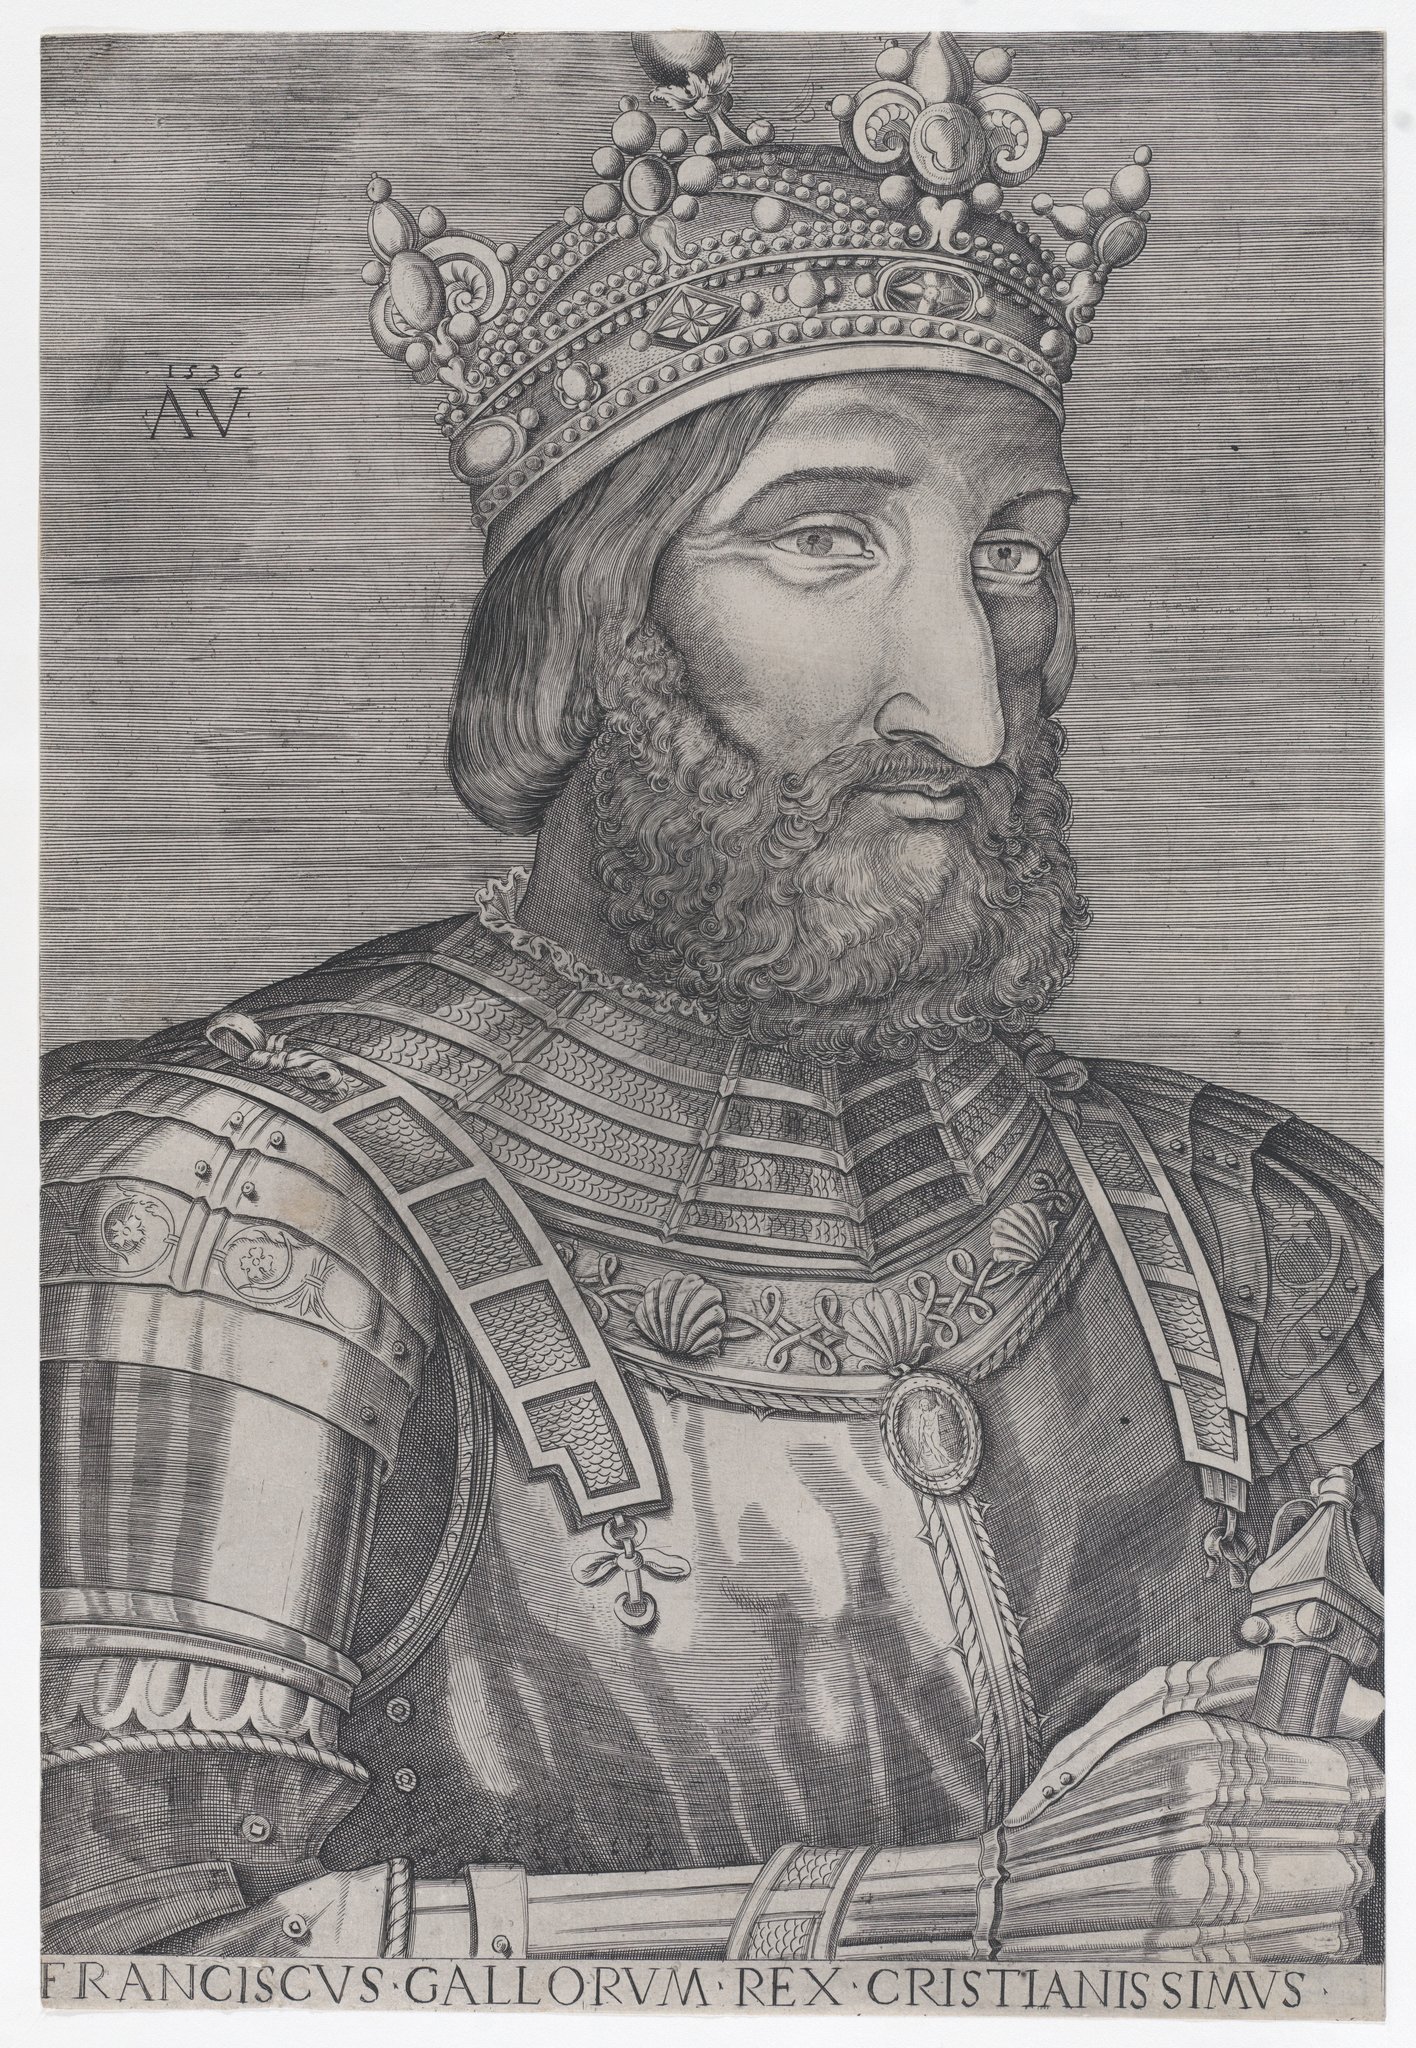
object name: print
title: Francois I, King of France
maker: agostino veneziano (agostino dei musi)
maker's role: artist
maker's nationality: italian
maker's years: 1490-1536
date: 1536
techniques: engraving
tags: armor,kings,men,crowns